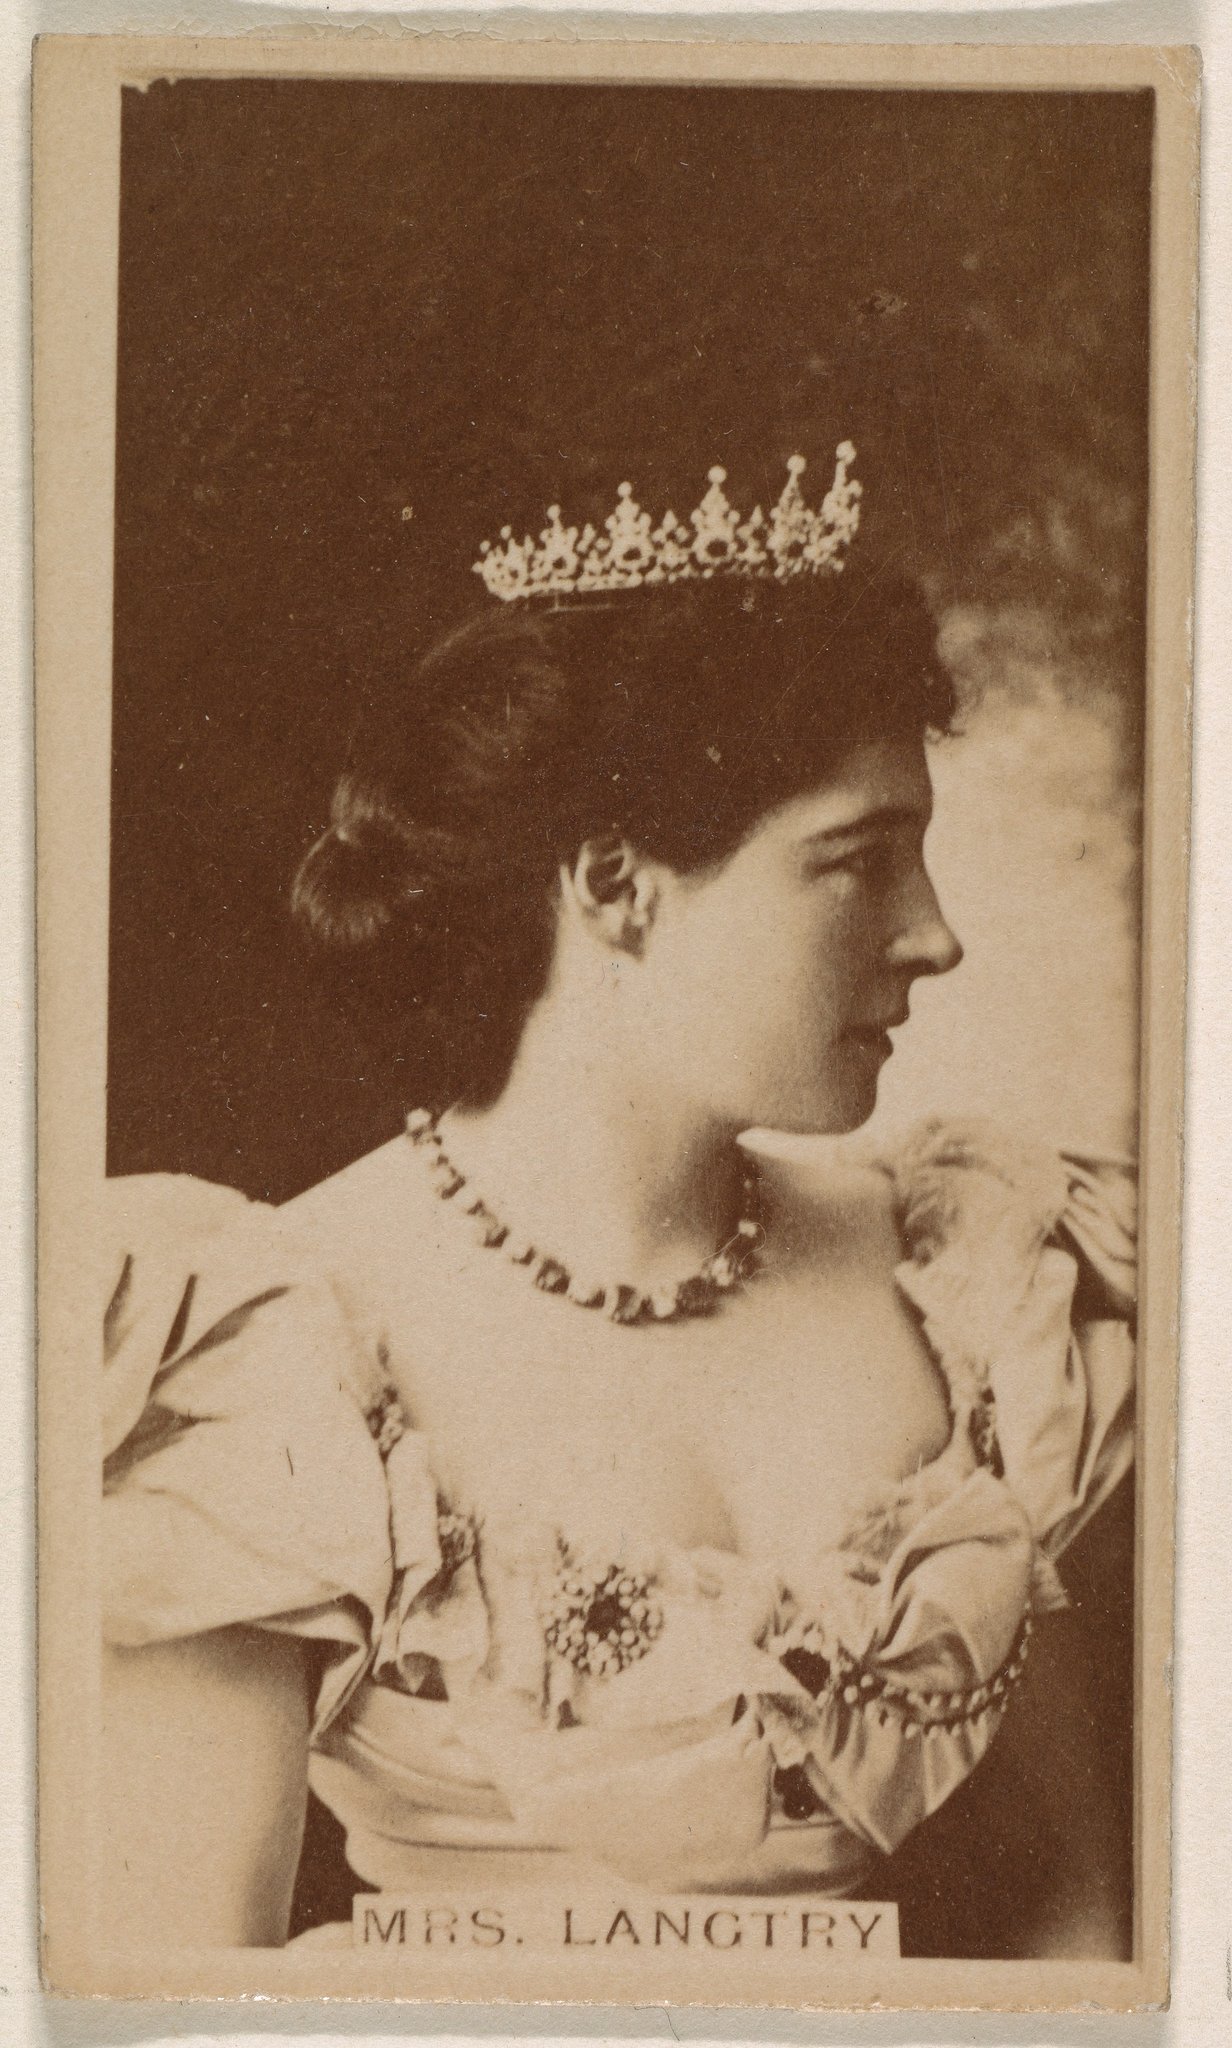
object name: photograph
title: Mrs. Langtry, from the Actresses series (N245) issued by Kinney Brothers to promote Sweet Caporal Cigarettes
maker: kinney brothers tobacco company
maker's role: publisher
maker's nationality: american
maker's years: 1869-2011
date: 1890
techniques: albumen silver print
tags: women,actresses